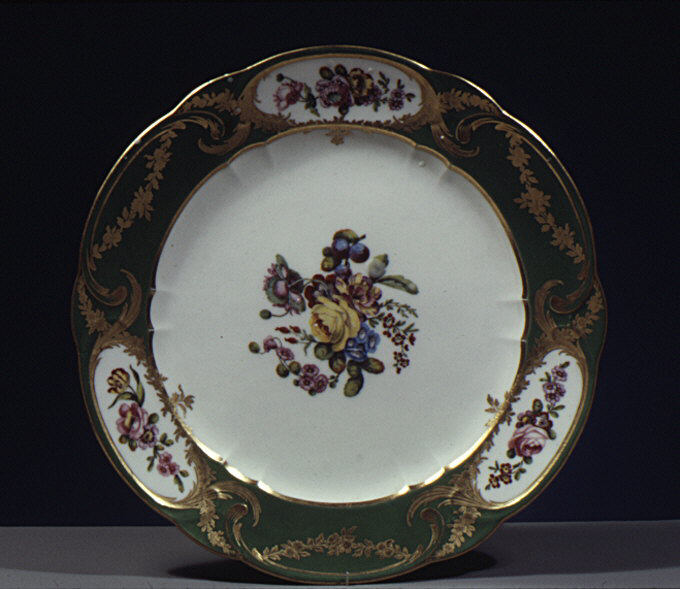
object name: plate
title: Plate (assiette à palmes) (1 of 102) (part of a service)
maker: sèvres manufactory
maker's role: manufactory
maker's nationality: french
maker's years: 1740-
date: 1772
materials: soft paste porcelain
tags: flowers